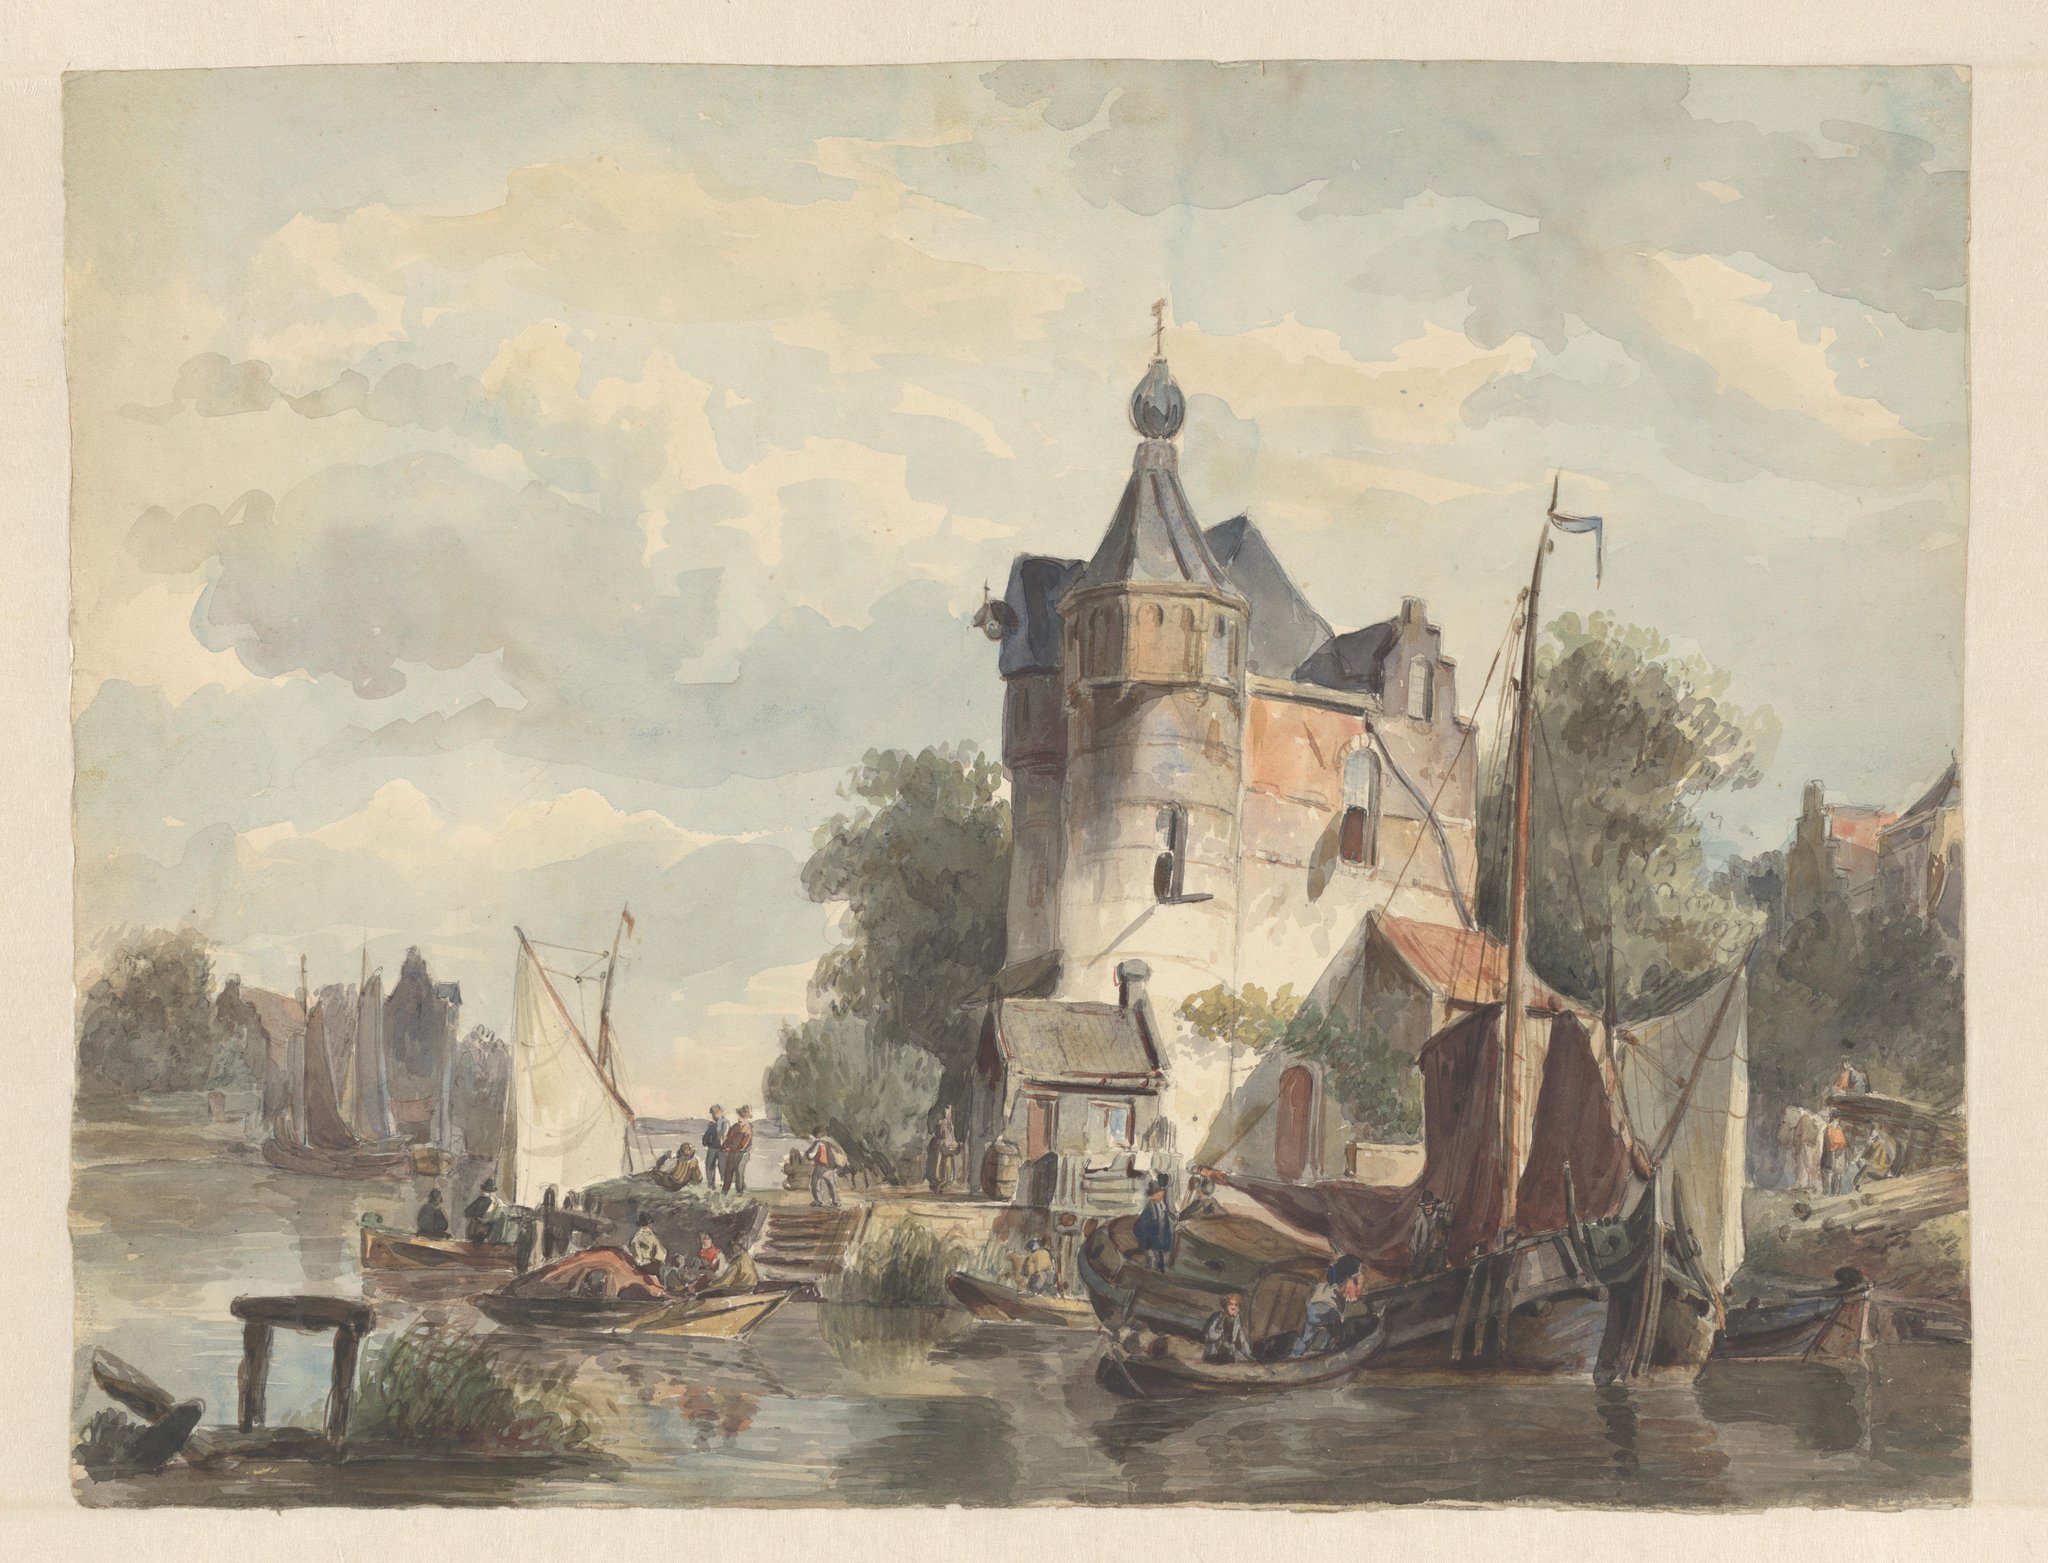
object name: drawing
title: Riviergezicht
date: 1840-1860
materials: chalk, paper, pencil, watercolor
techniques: brush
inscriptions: number: ‘00:501’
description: Riviergezicht met boten, en gebouwen op de oever